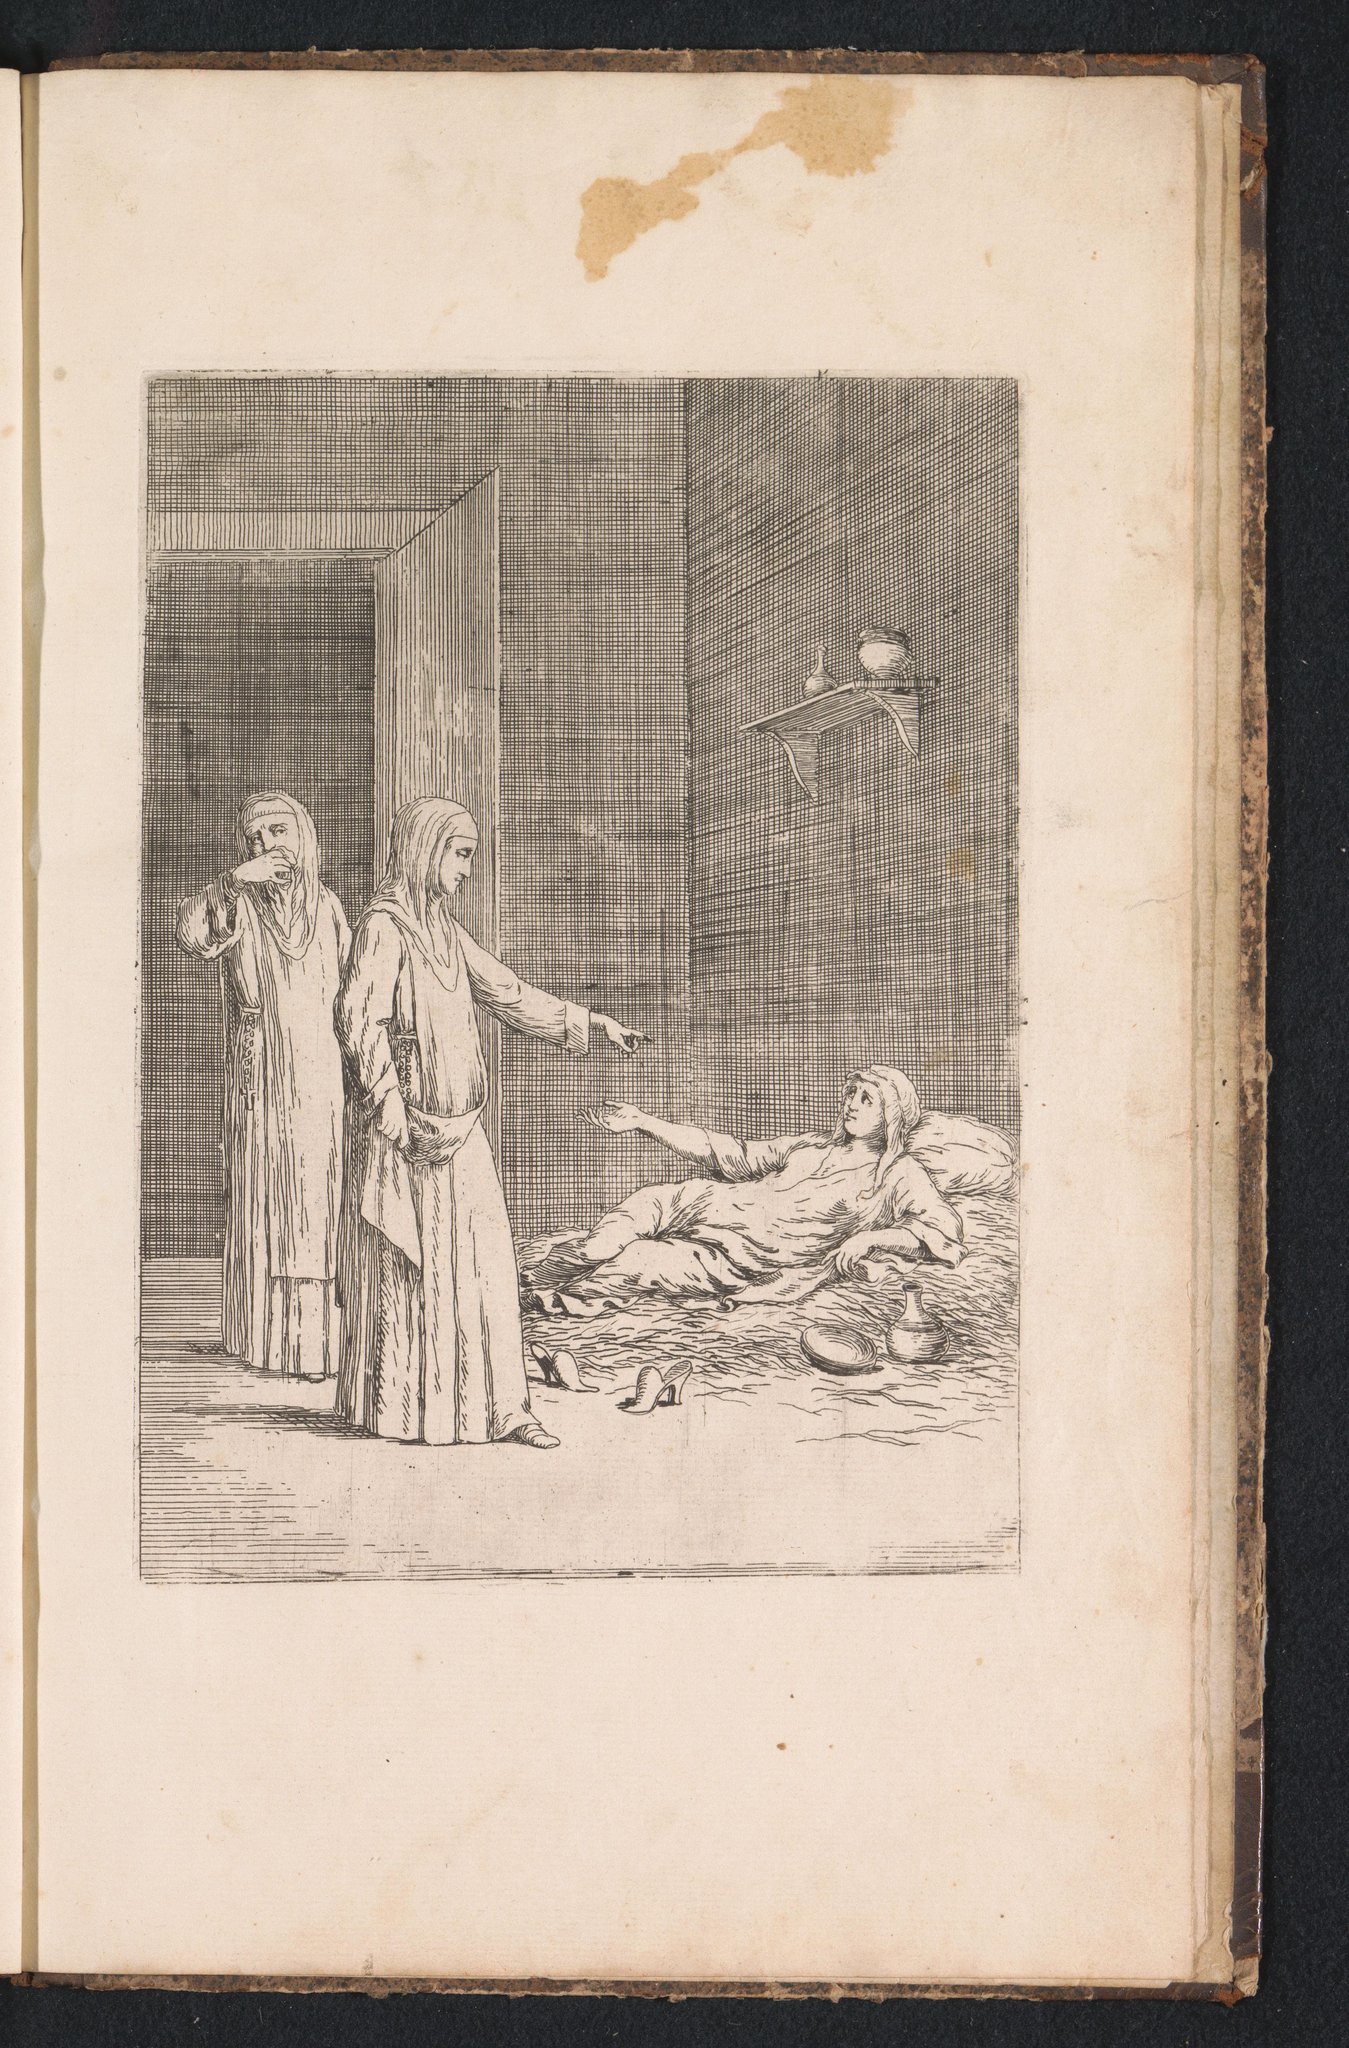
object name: print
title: Marie-Catherine Cadière belandt in een kerker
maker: jacques gabriel huquier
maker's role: draughtsman, painter, print maker, publisher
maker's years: 1725-1805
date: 1735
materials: paper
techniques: etching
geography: france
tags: toulon, sexual abuses of monks, witch-hunt, persecution of witches and sorcerers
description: Jean-Baptiste Girard beschuldigt Marie-Catherine Cadière van hekserij, hier voor wordt zij in een stinkende kerker opgesloten. Onderdeel van de reeks van 32, veelal erotisch getinte, prenten gewijd aan het schandaal rond Marie-Catherine Cadière en de Jezuïet Jean-Baptiste Girard in 1730-1731.